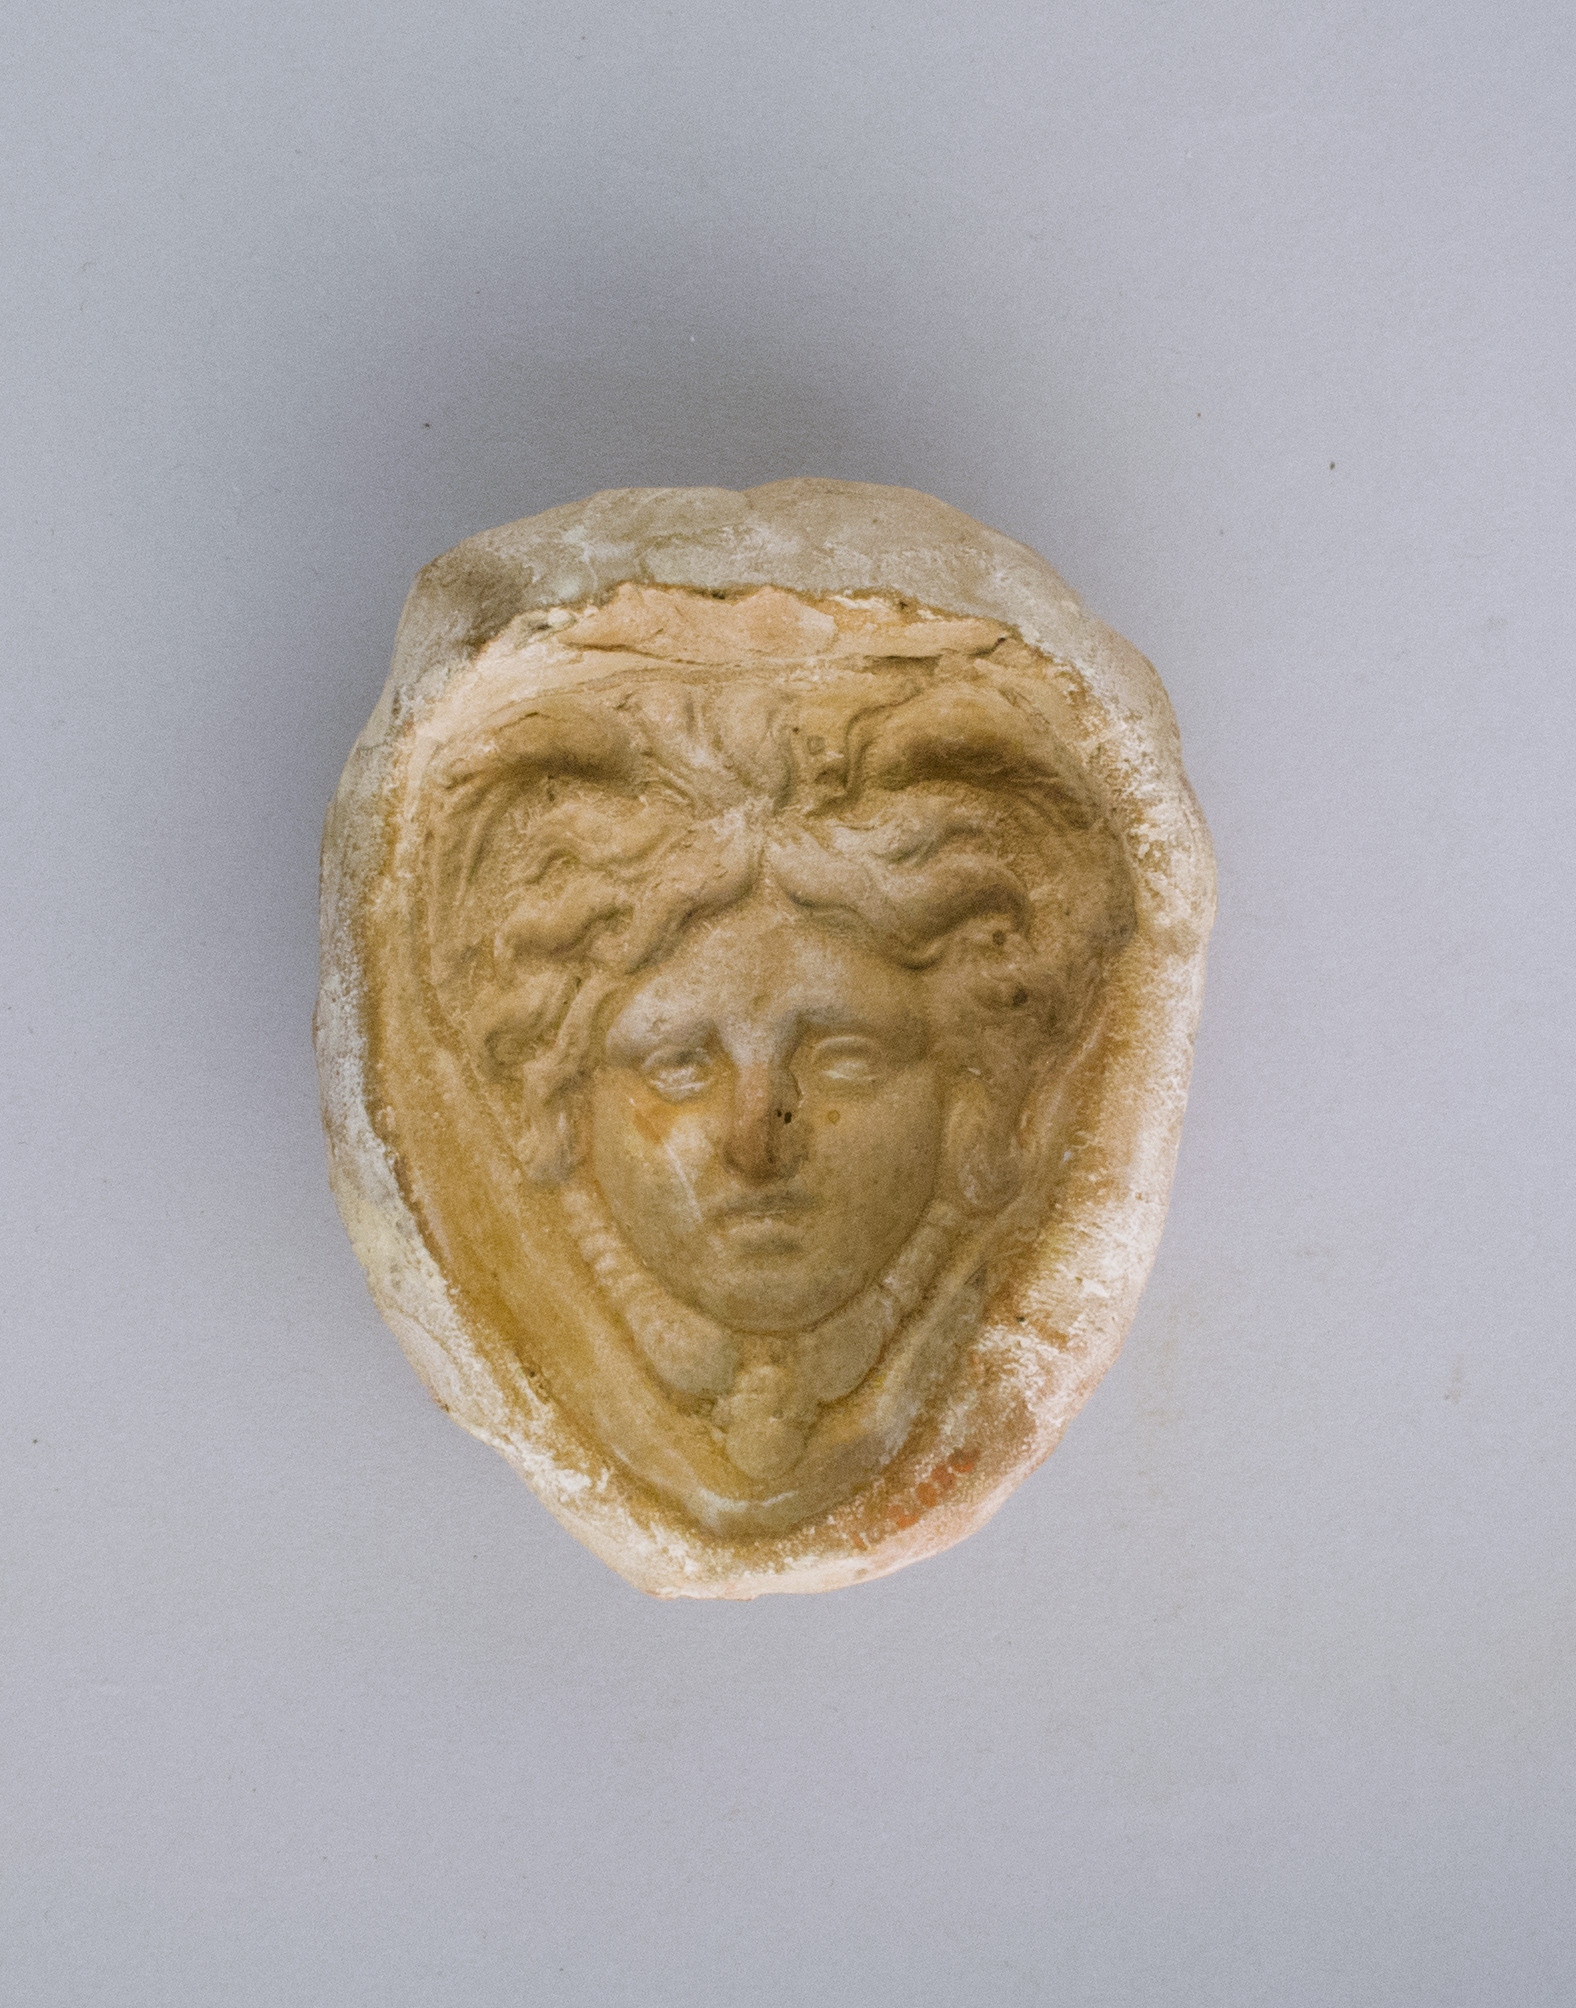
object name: mold of head of medusa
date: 7000 BCE-330 CE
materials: terracotta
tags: heads,medusa